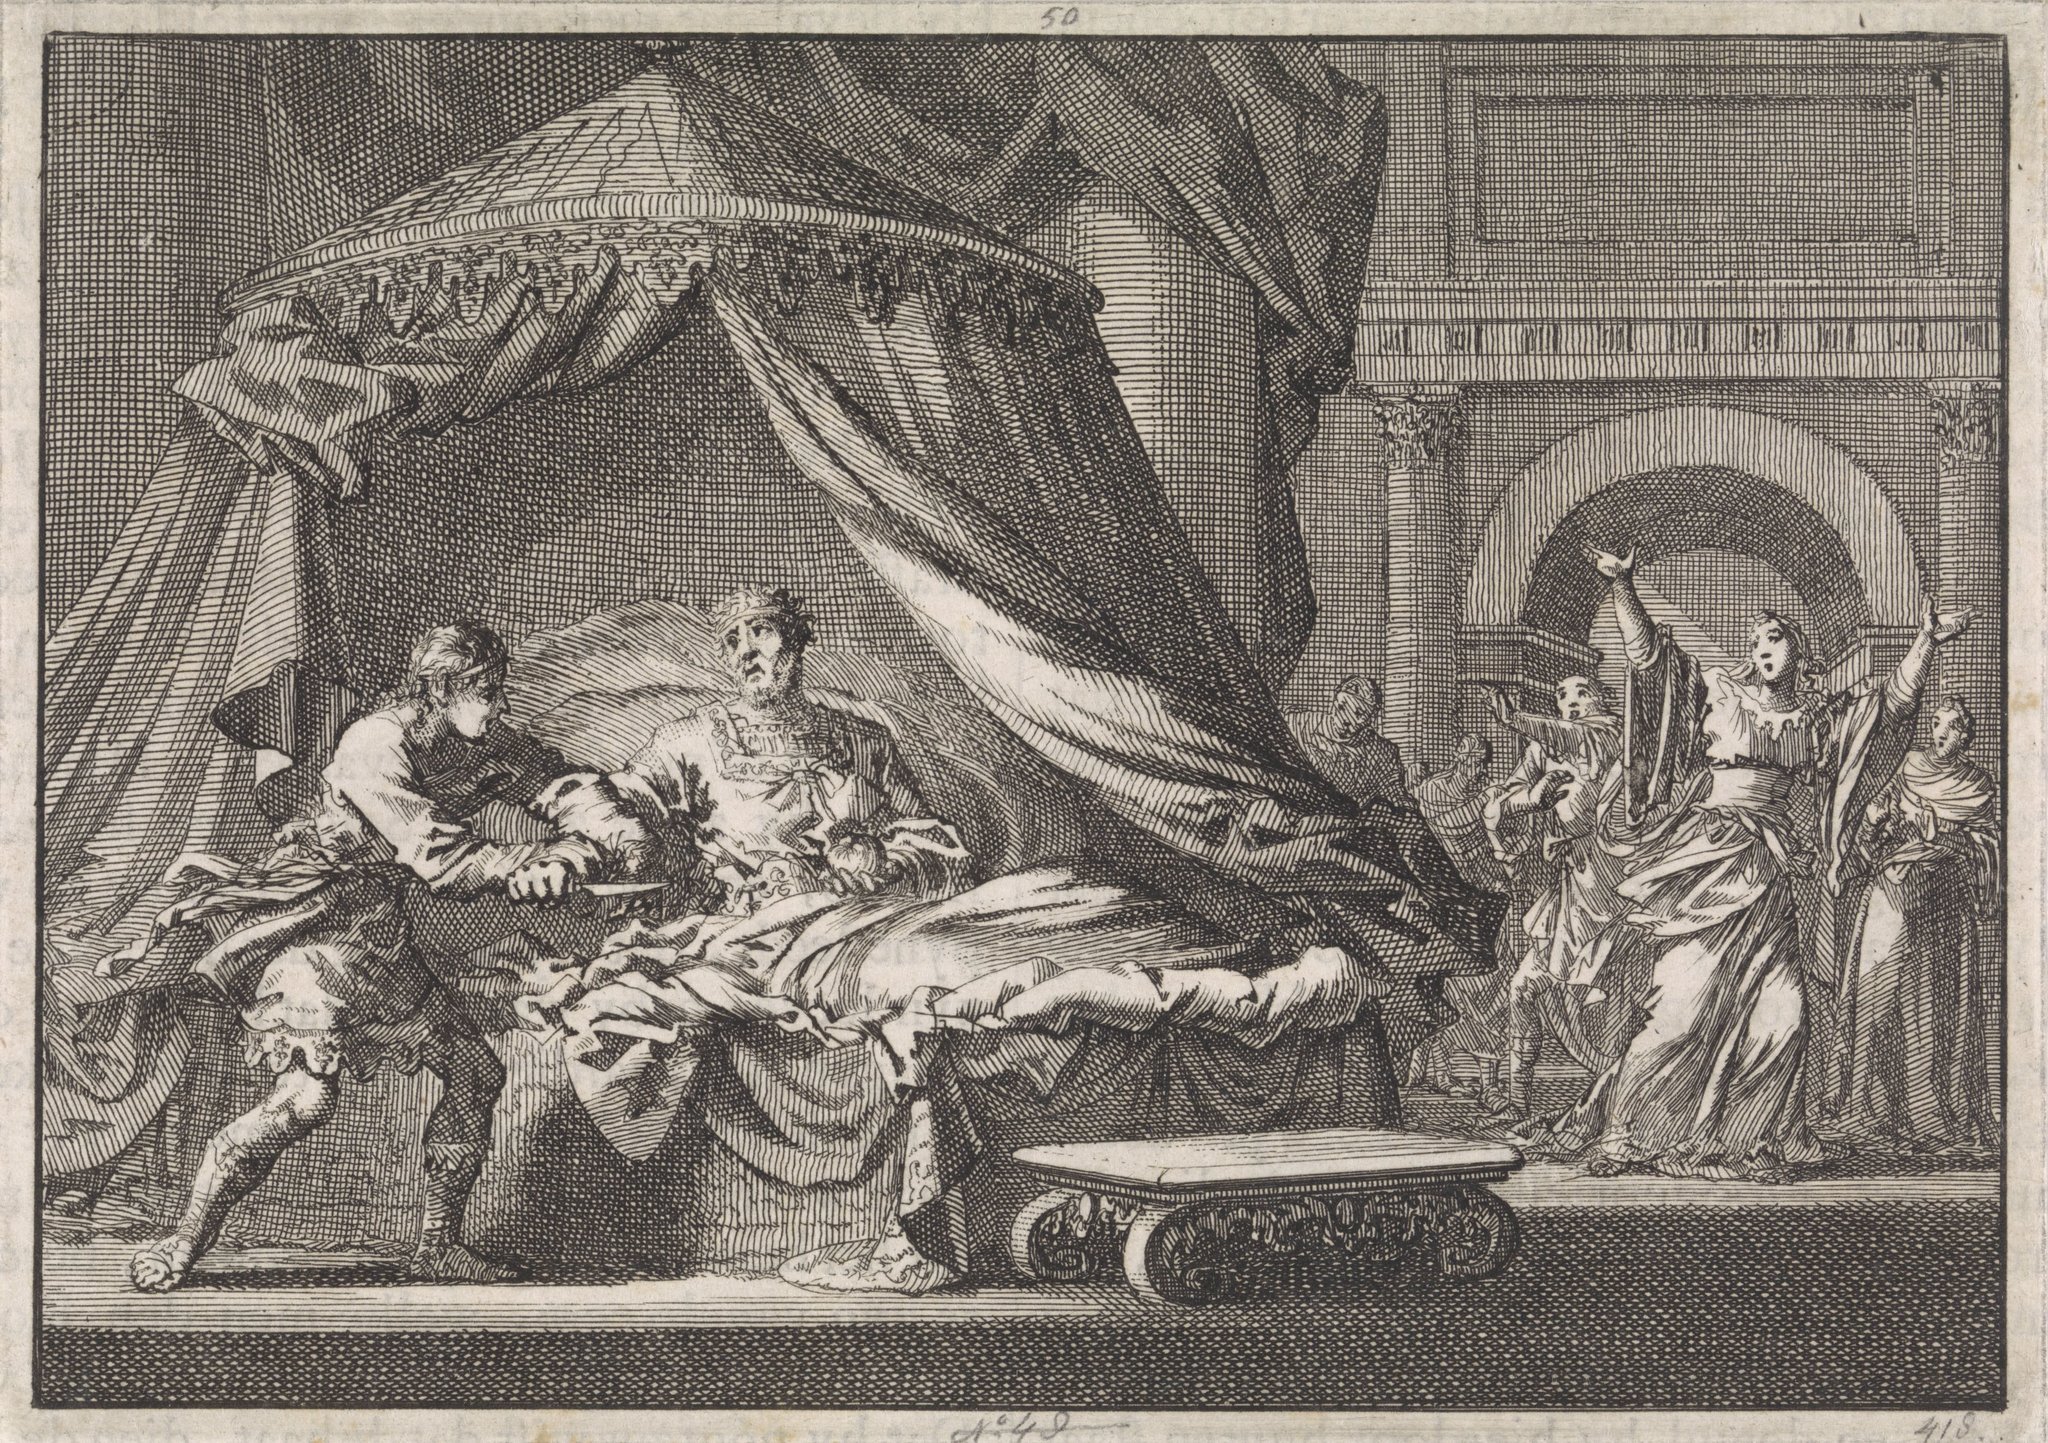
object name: book illustration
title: Achiab verhindert de zelfmoord van zijn grootvader Herodes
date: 1704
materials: paper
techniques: etching, letterpress printing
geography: amsterdam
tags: seeking death, suicide - ee - death not certain; wounded person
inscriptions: collector's mark: Lugt 2228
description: Prent opgenomen in: Josephus, Flavius. Alle de Werken, 2 delen. Amsterdam: Pieter Mortier, 1704, dl. 1, p. 418.